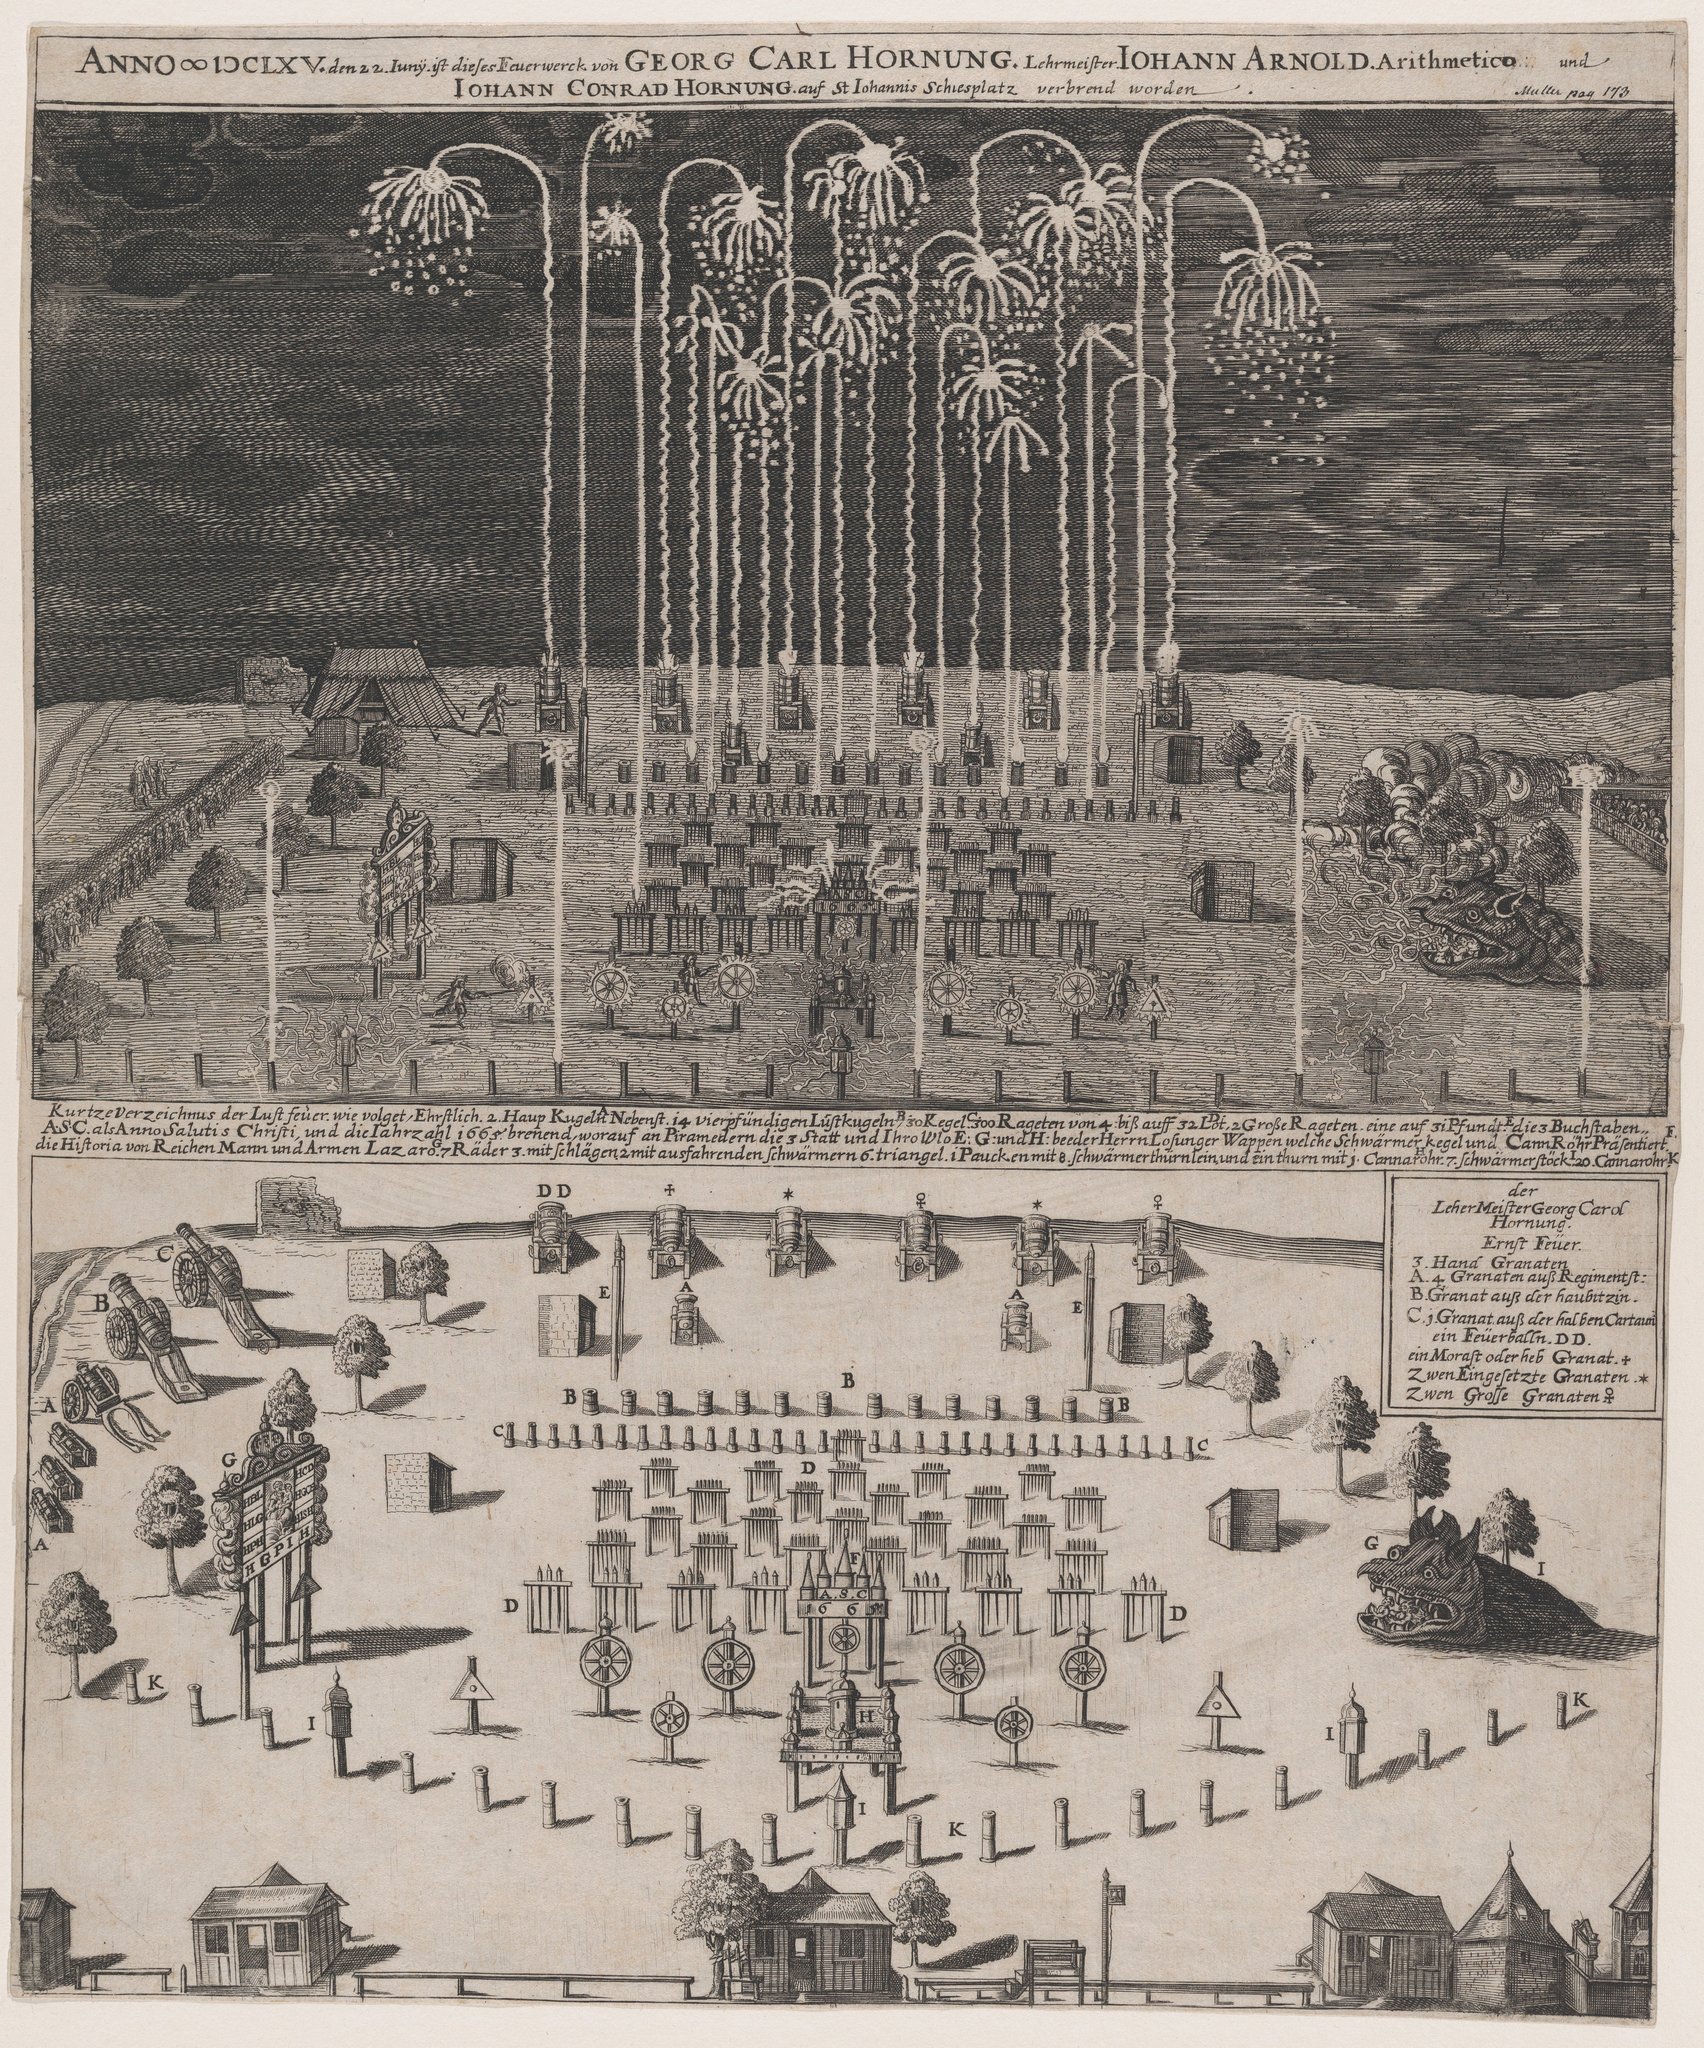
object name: print, fete, ornament architecture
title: Fireworks on the Schiessplatz, Nuremberg, June 22, 1665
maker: georg carl hornung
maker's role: designer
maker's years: 1600-1700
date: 1665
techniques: etching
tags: fireworks